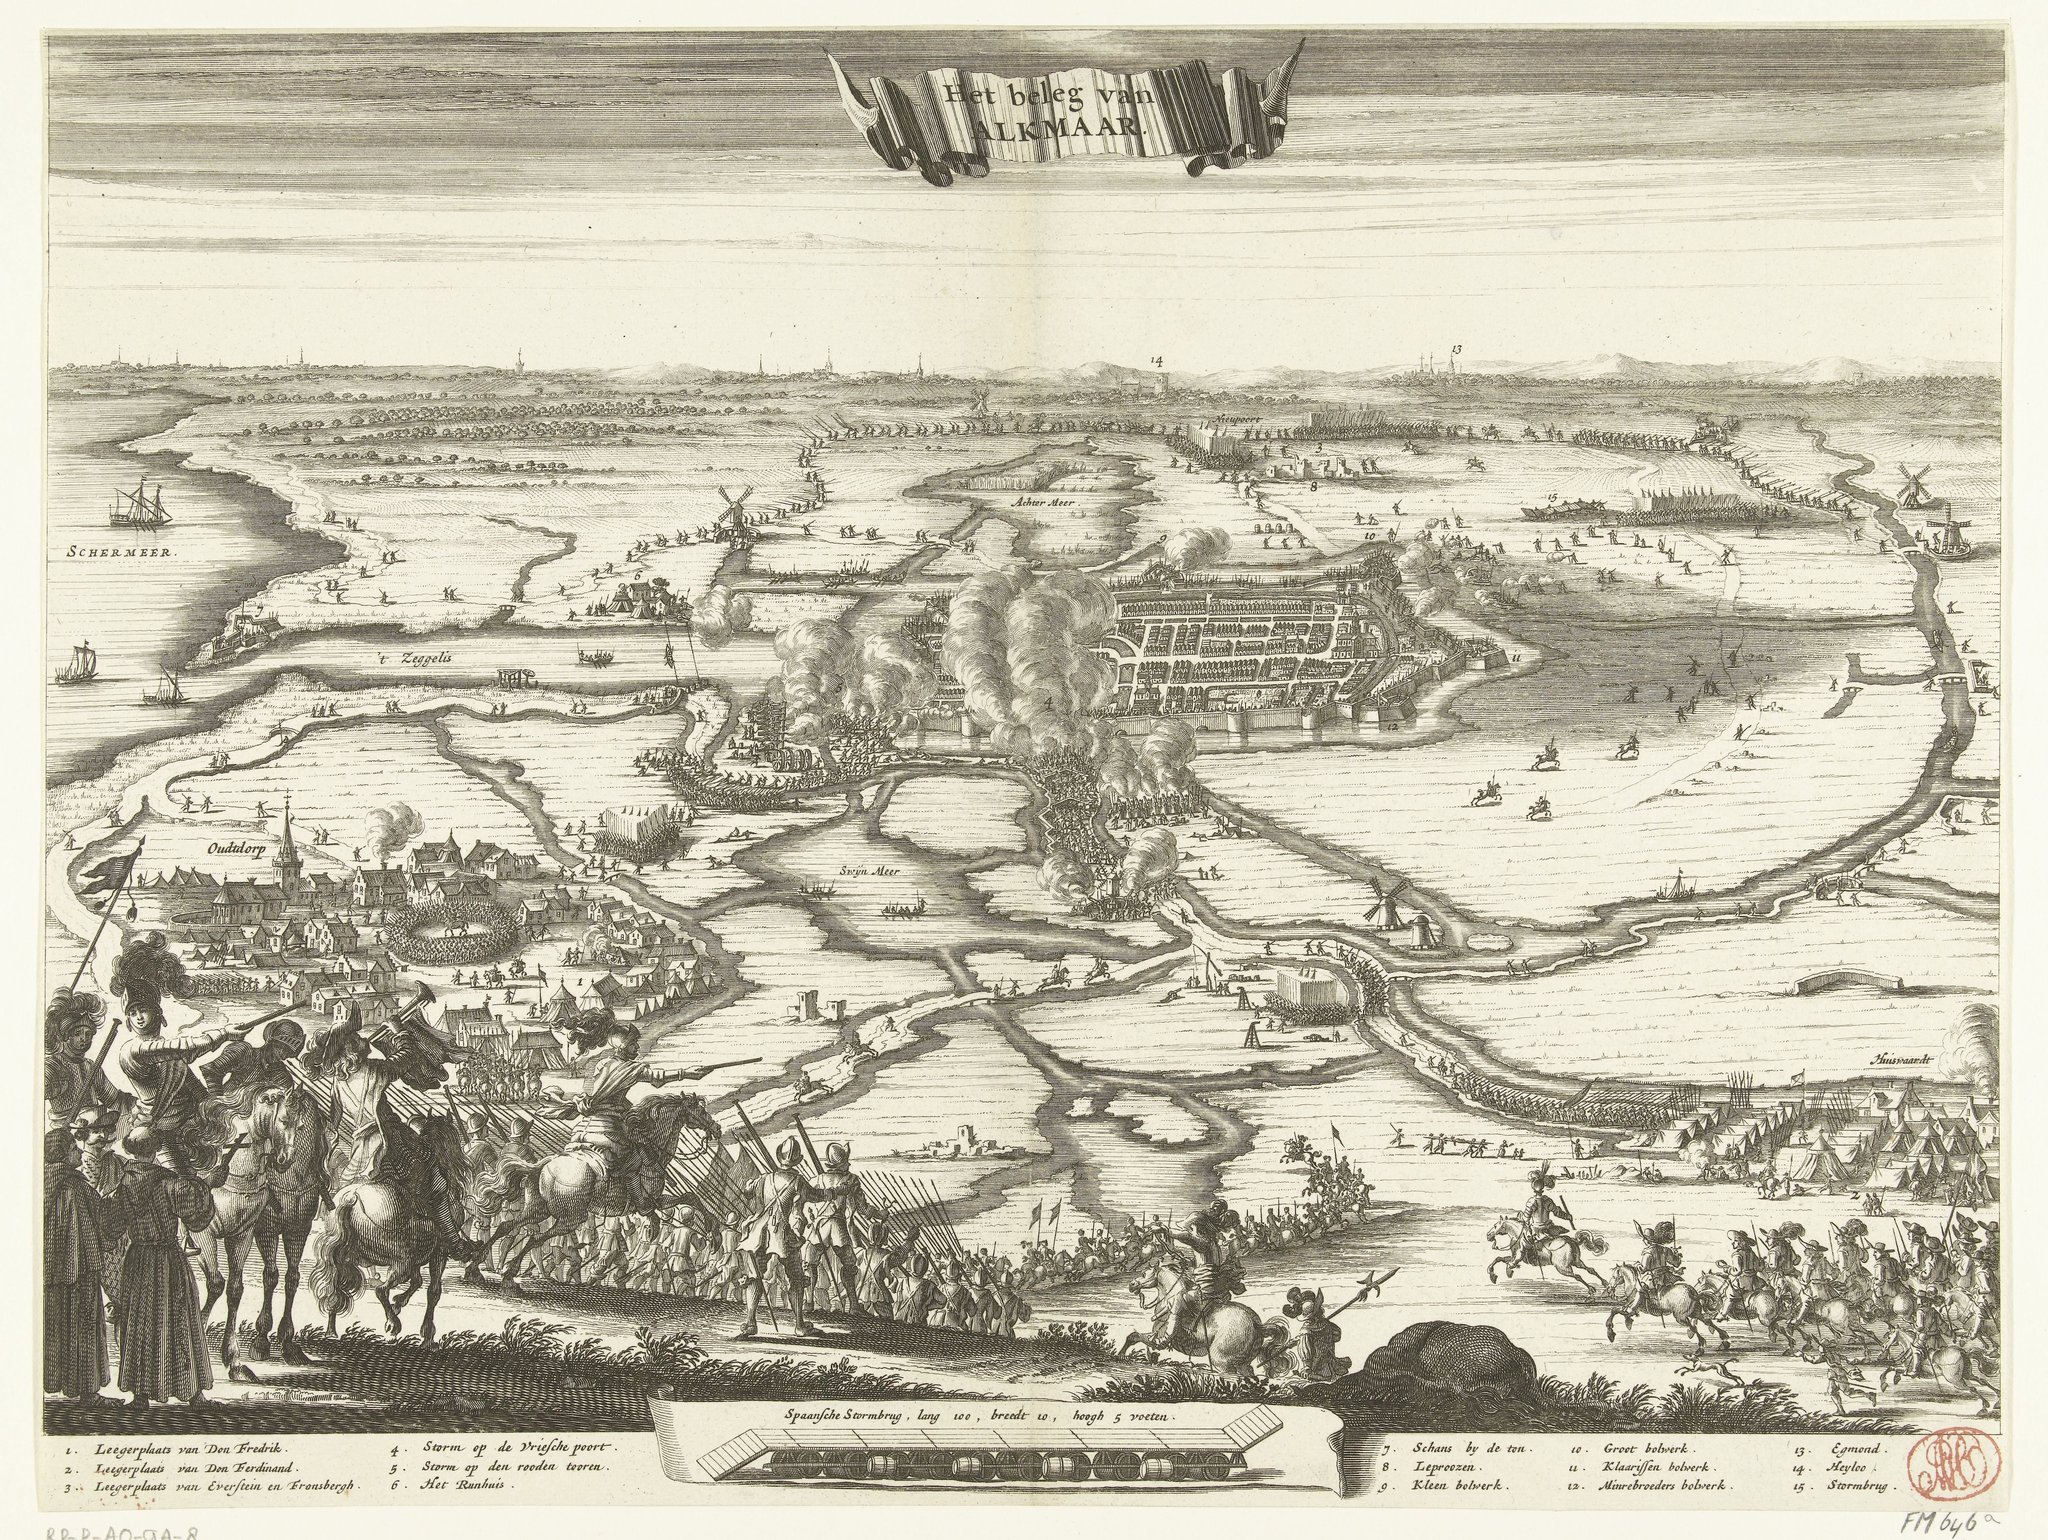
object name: history print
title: Beleg van Alkmaar, 1573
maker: coenraet decker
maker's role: print maker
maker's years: 1650-1685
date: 1701-1703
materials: paper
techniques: etching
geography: northern netherlands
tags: siege, position war, siege arms, e.g.: battering ram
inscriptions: collector's mark: Lugt 195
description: Illustratie voor P.C. Hoofts Nederlandsche historien, seedert de ooverdraght der heerschappye van kaizar Karel den Vyfden op koning Philips zynen zoon, tot het einde der landtvooghdye des graven van Leicester, 1703, dl. I, p. 332/333. Deze staat vóór de staat beschreven in Muller.